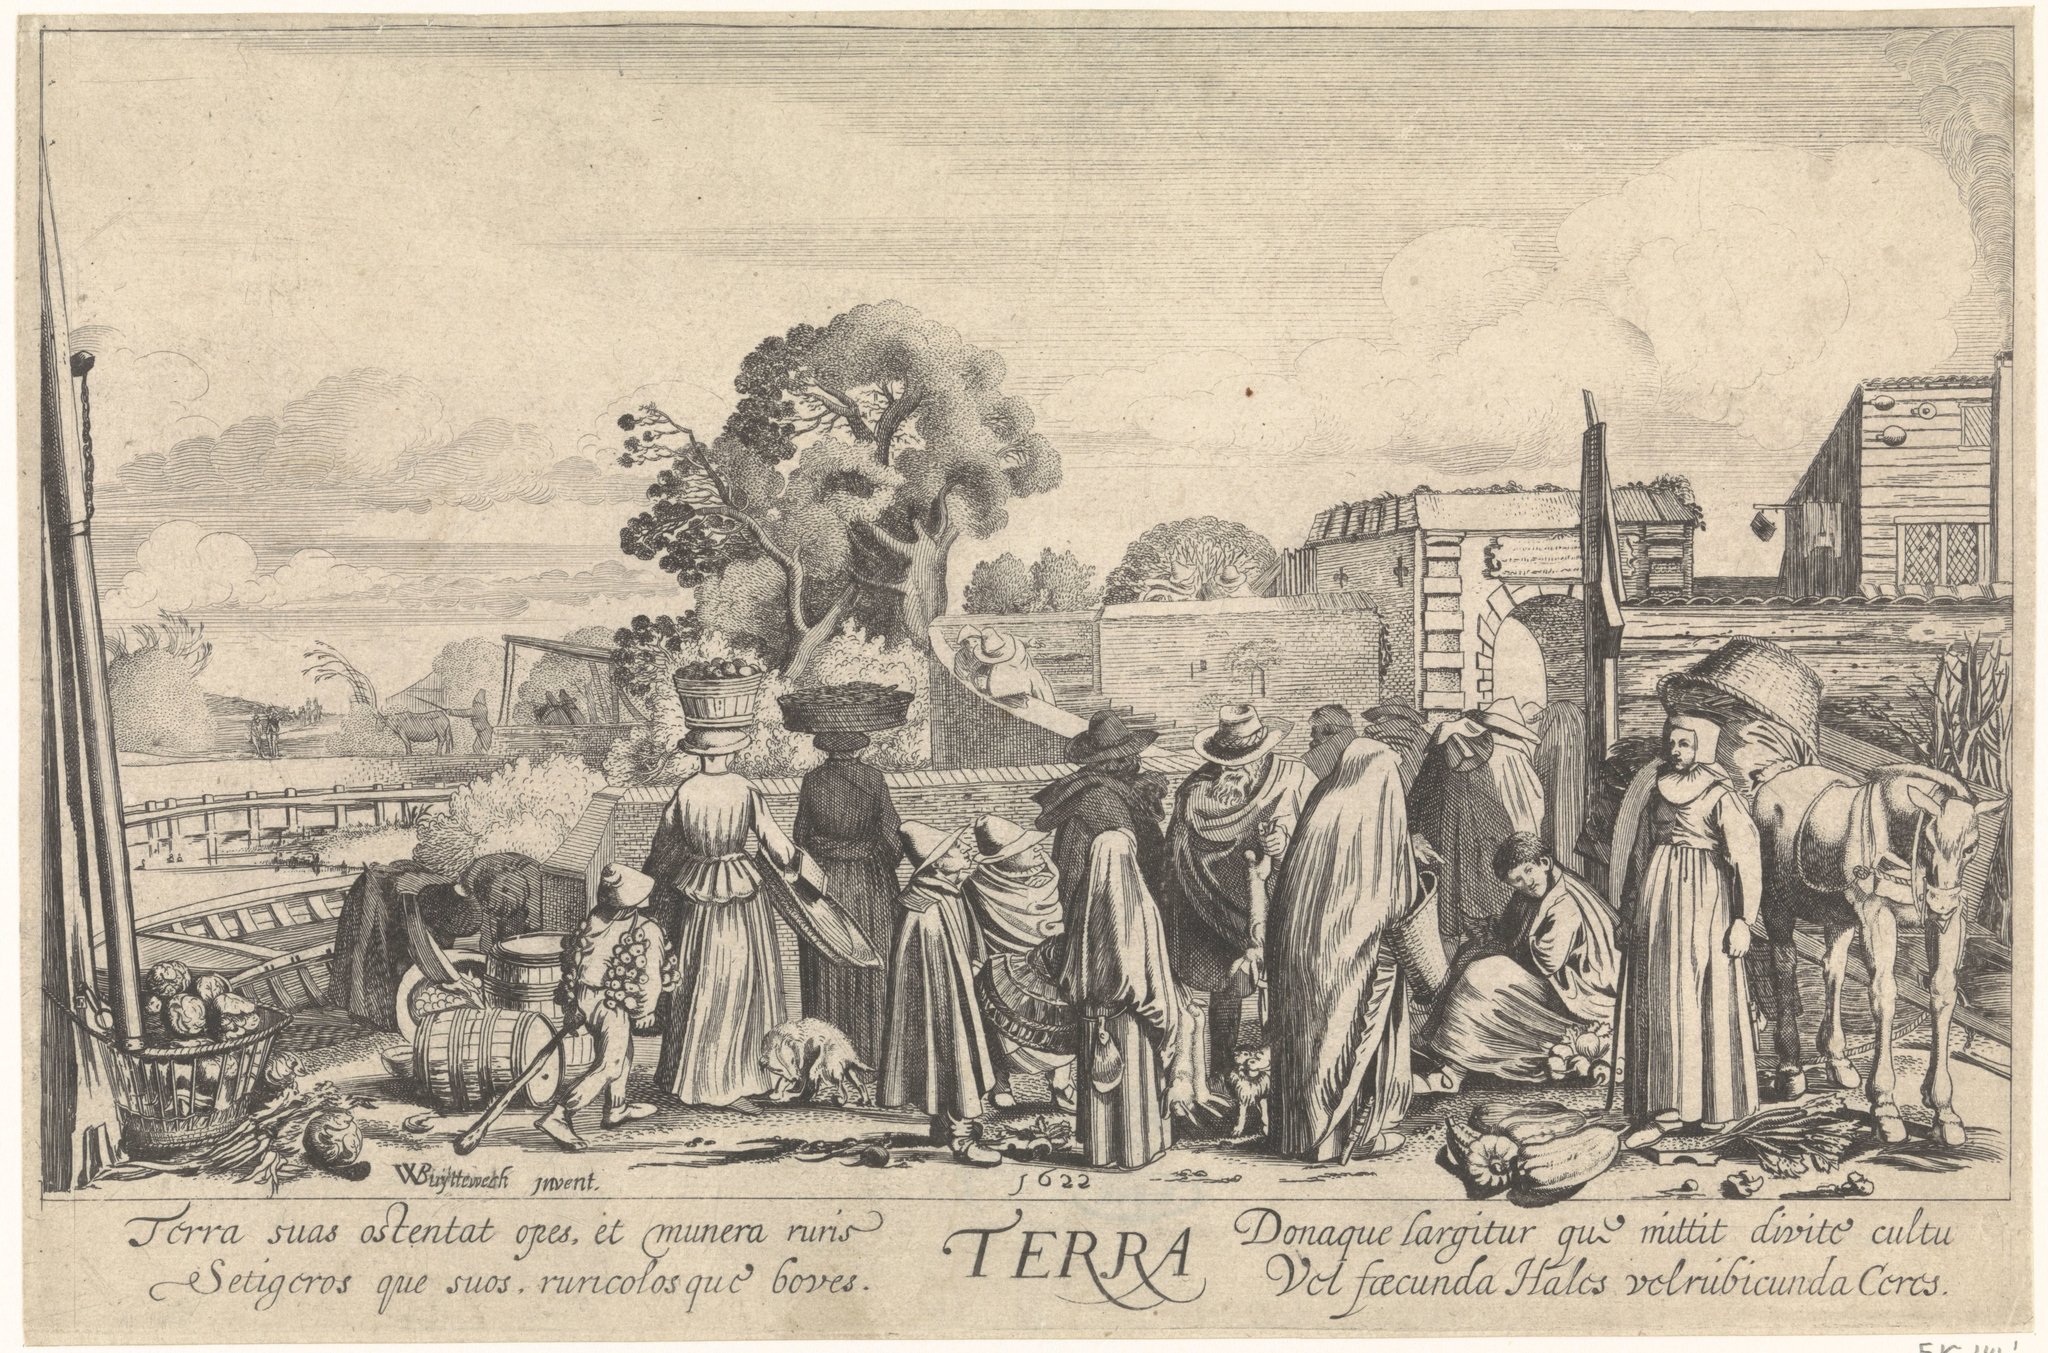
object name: print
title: De vier elementen B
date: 1622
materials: paper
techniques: engraving, etching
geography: northern netherlands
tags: earth (one of the four elements), going to the market, 'terra', 'carro della terra' (ripa), market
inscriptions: collector's mark: Lugt 1120, collector's mark: Lugt 964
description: Landschap voorstellende het element aarde: vele figuren met manden op een markt waar de opbrengsten van het land worden verhandeld. Vierde prent uit een serie van vier met landschappen als verbeeldingen van de vier elementen.